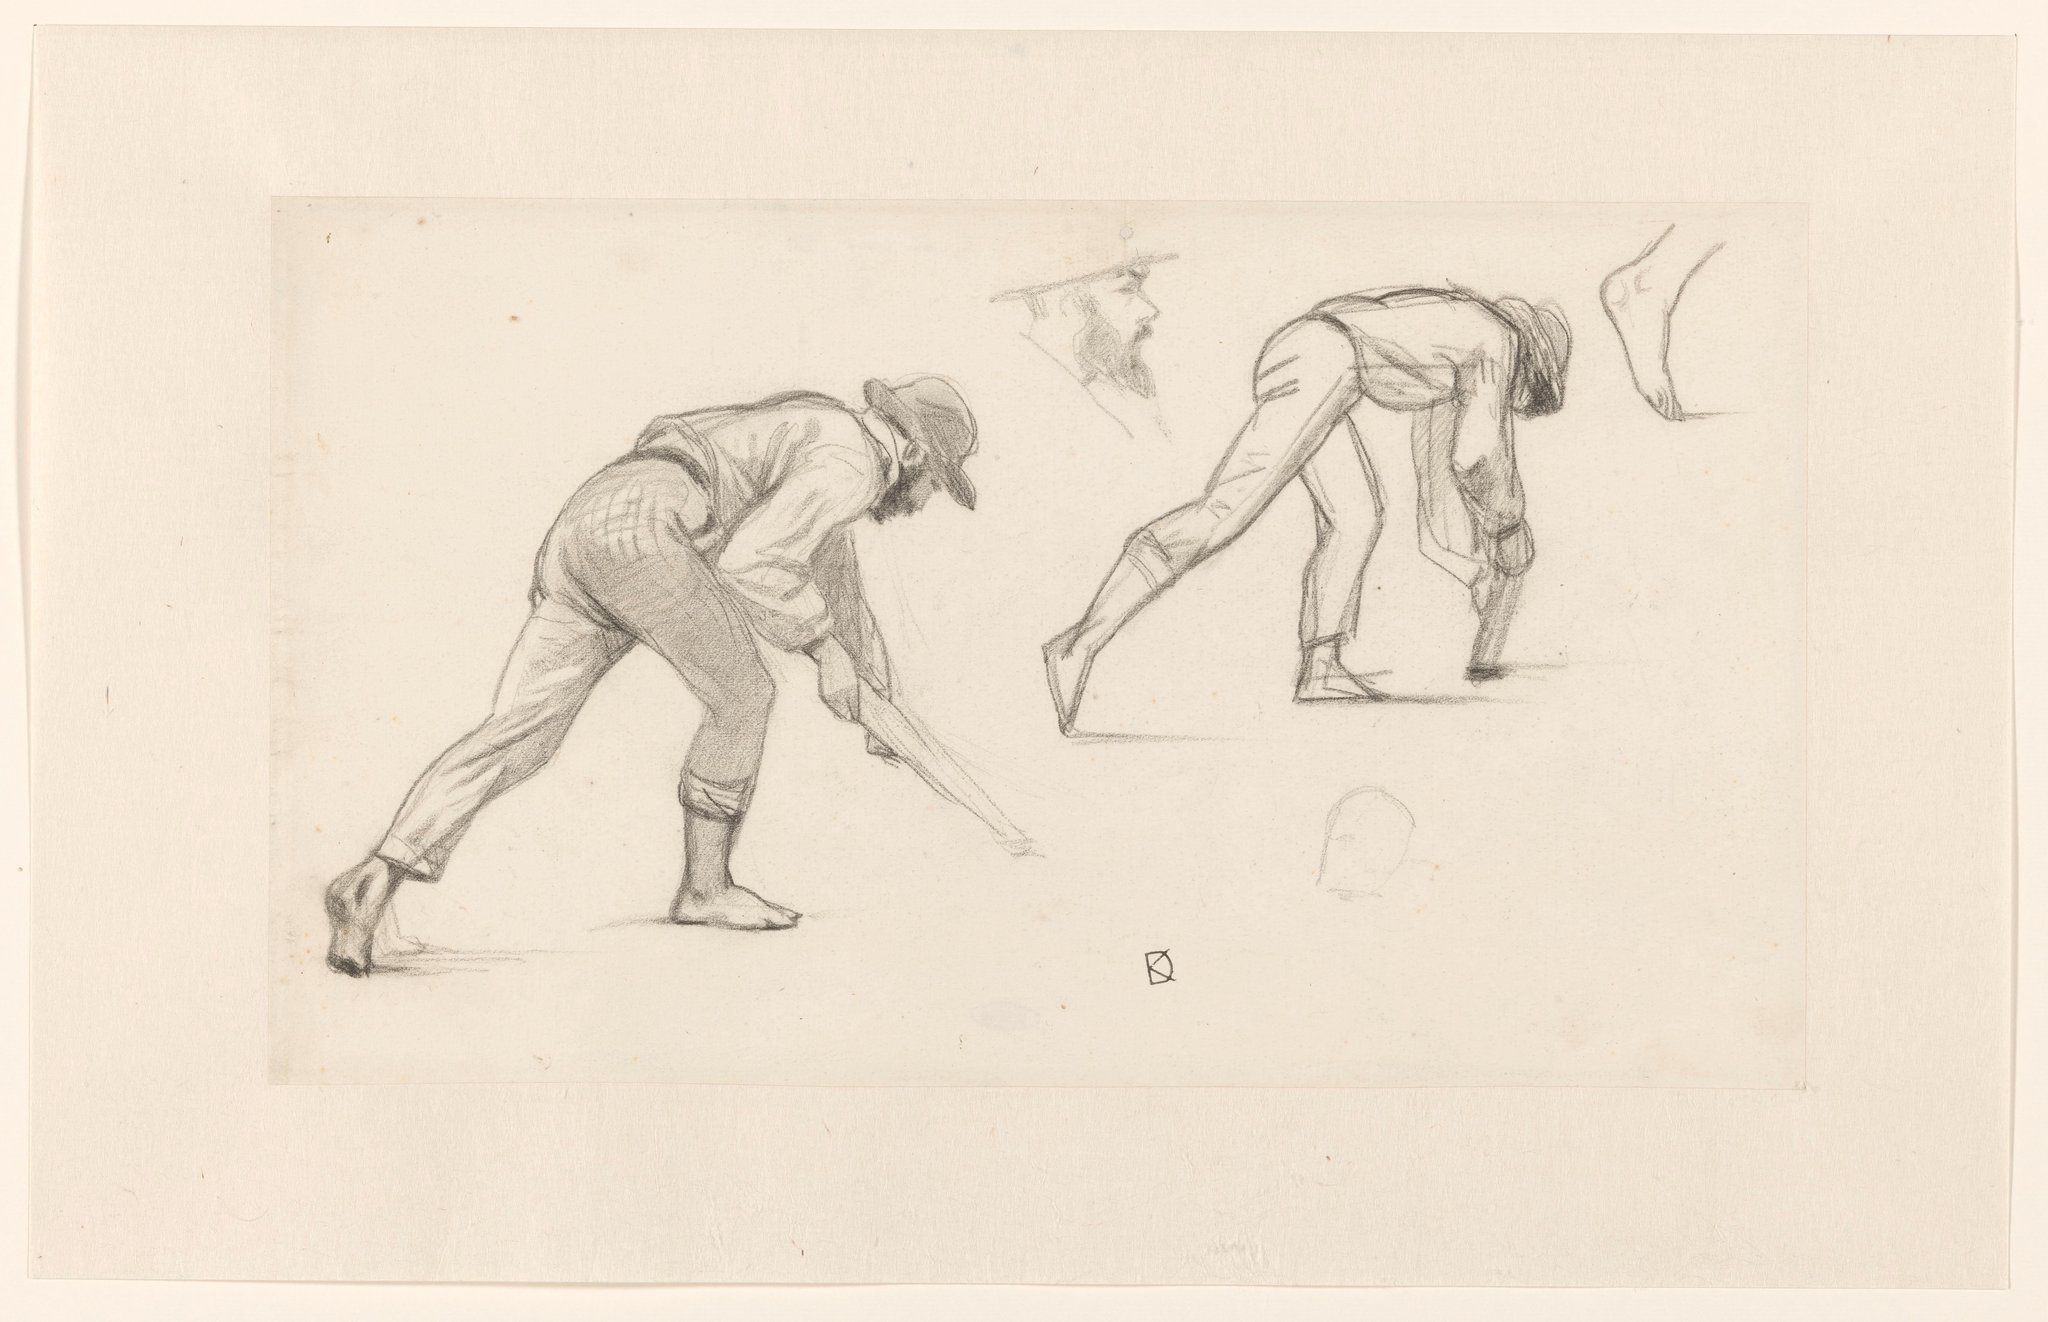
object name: drawing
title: Studies van een bukkende man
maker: johan daniël koelman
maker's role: draughtsman, print maker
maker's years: 1831-1857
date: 1841-1857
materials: chalk, paper